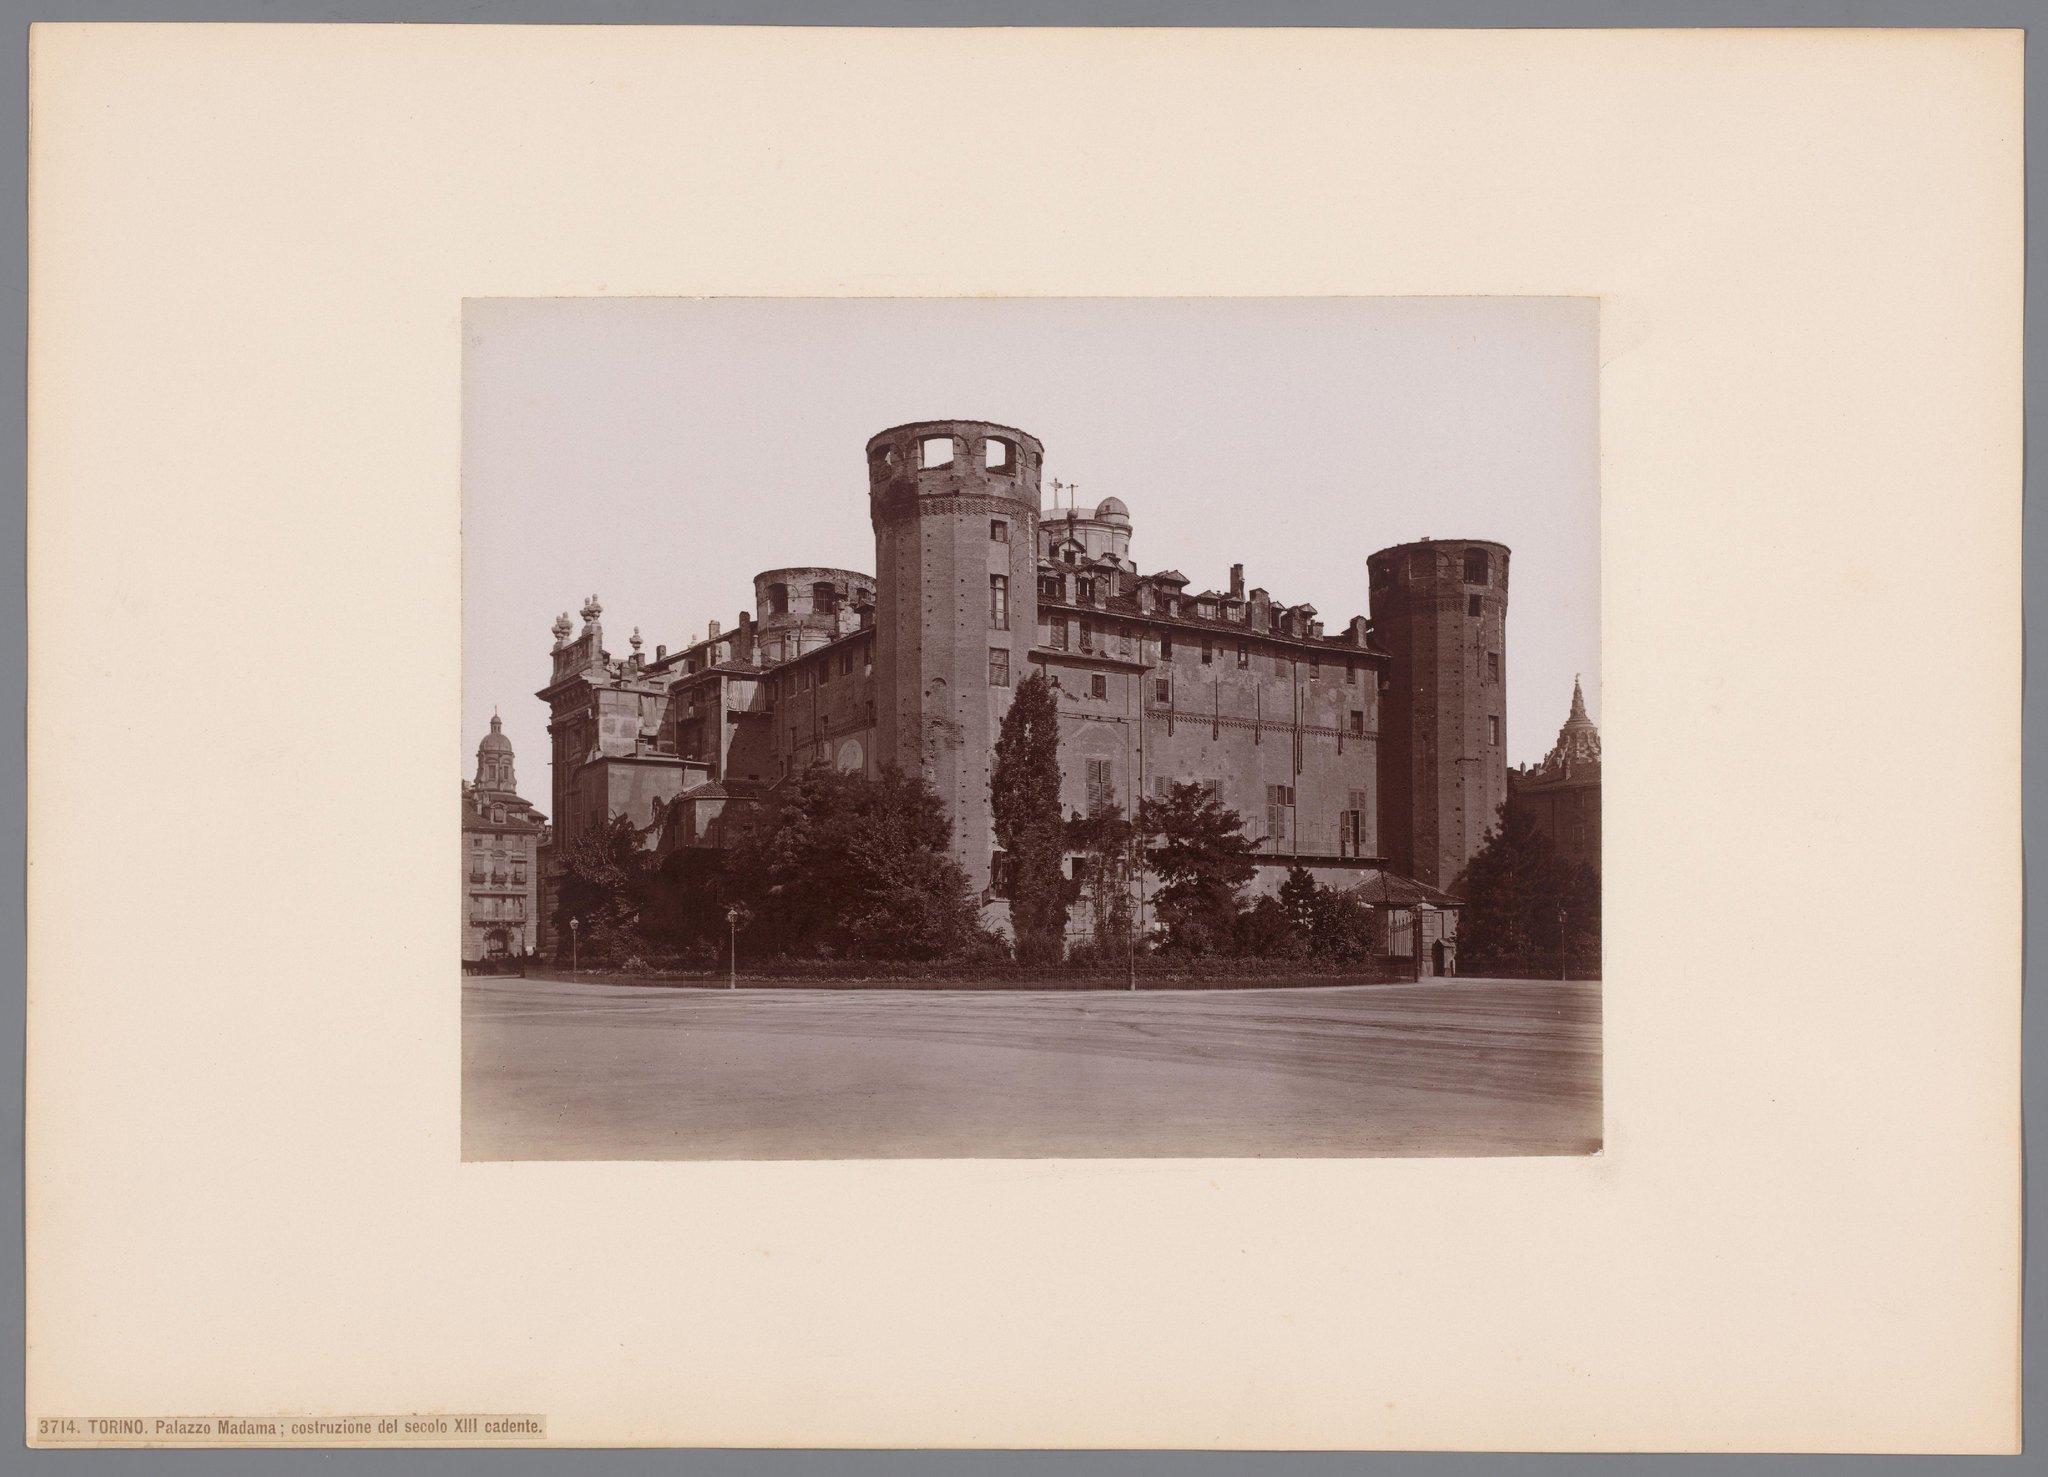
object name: photograph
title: Torino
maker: giacomo brogi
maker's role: fotograaf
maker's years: 1822-1881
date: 1864-1881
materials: cardboard, paper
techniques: albumen print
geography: turin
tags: palace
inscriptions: number: ‘3714.’, number: ‘19’